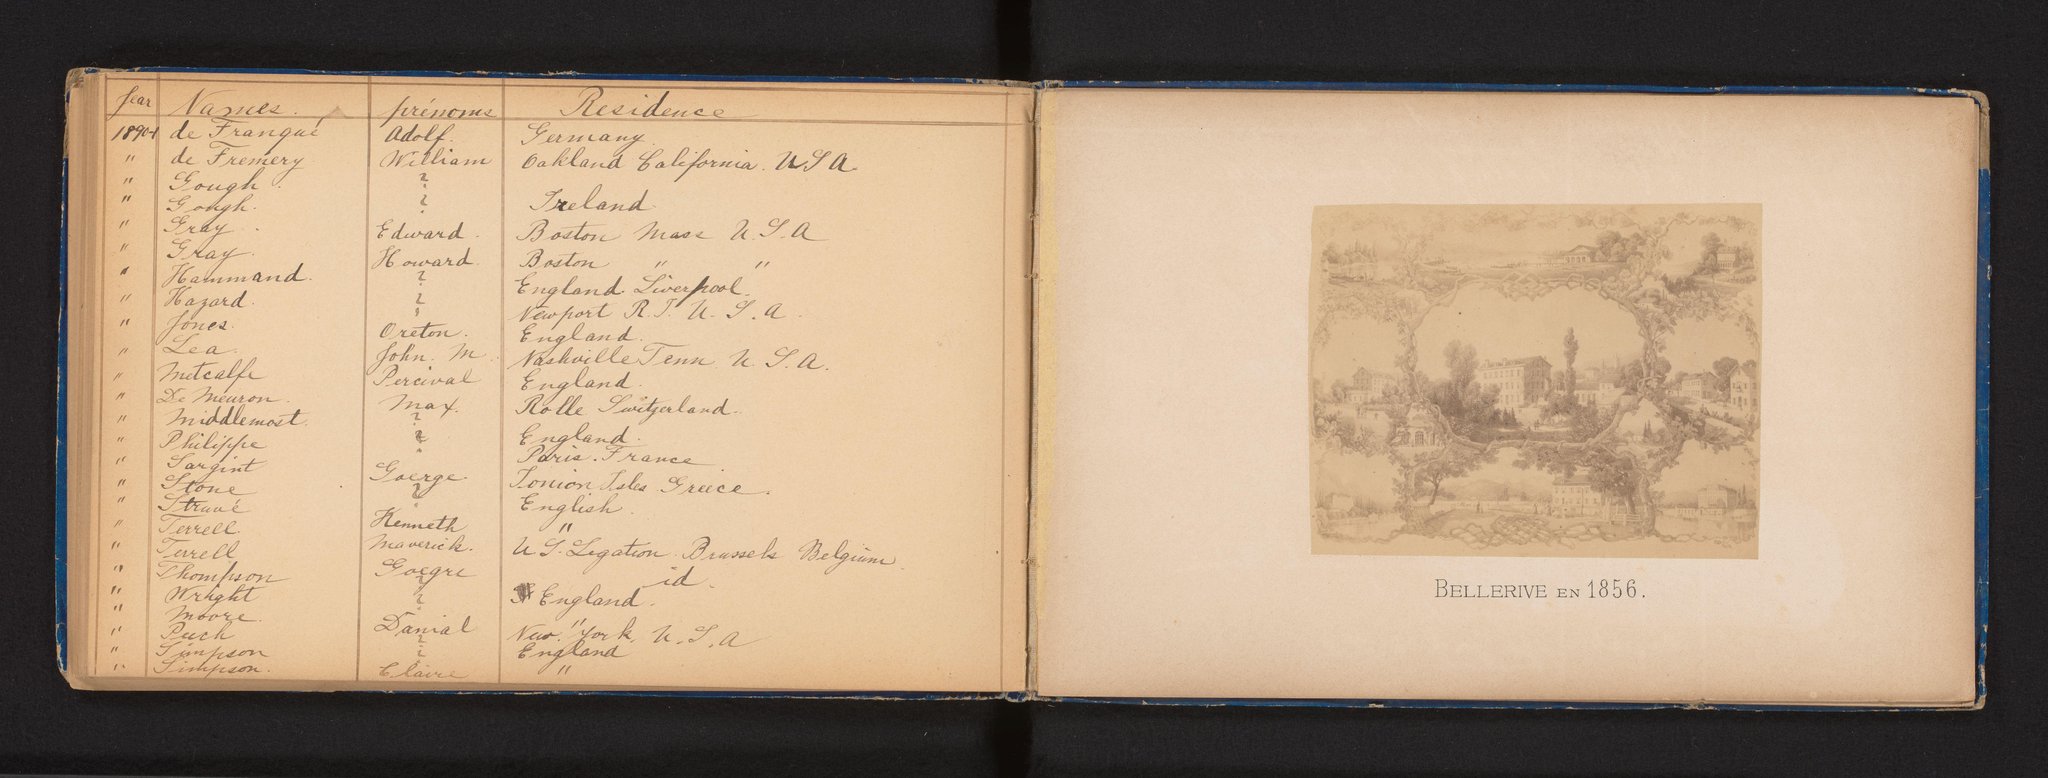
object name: photograph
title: Bellerive en 1856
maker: Anonymous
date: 1856-1886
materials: photographic support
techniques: albumen print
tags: hotel, hostelry, inn